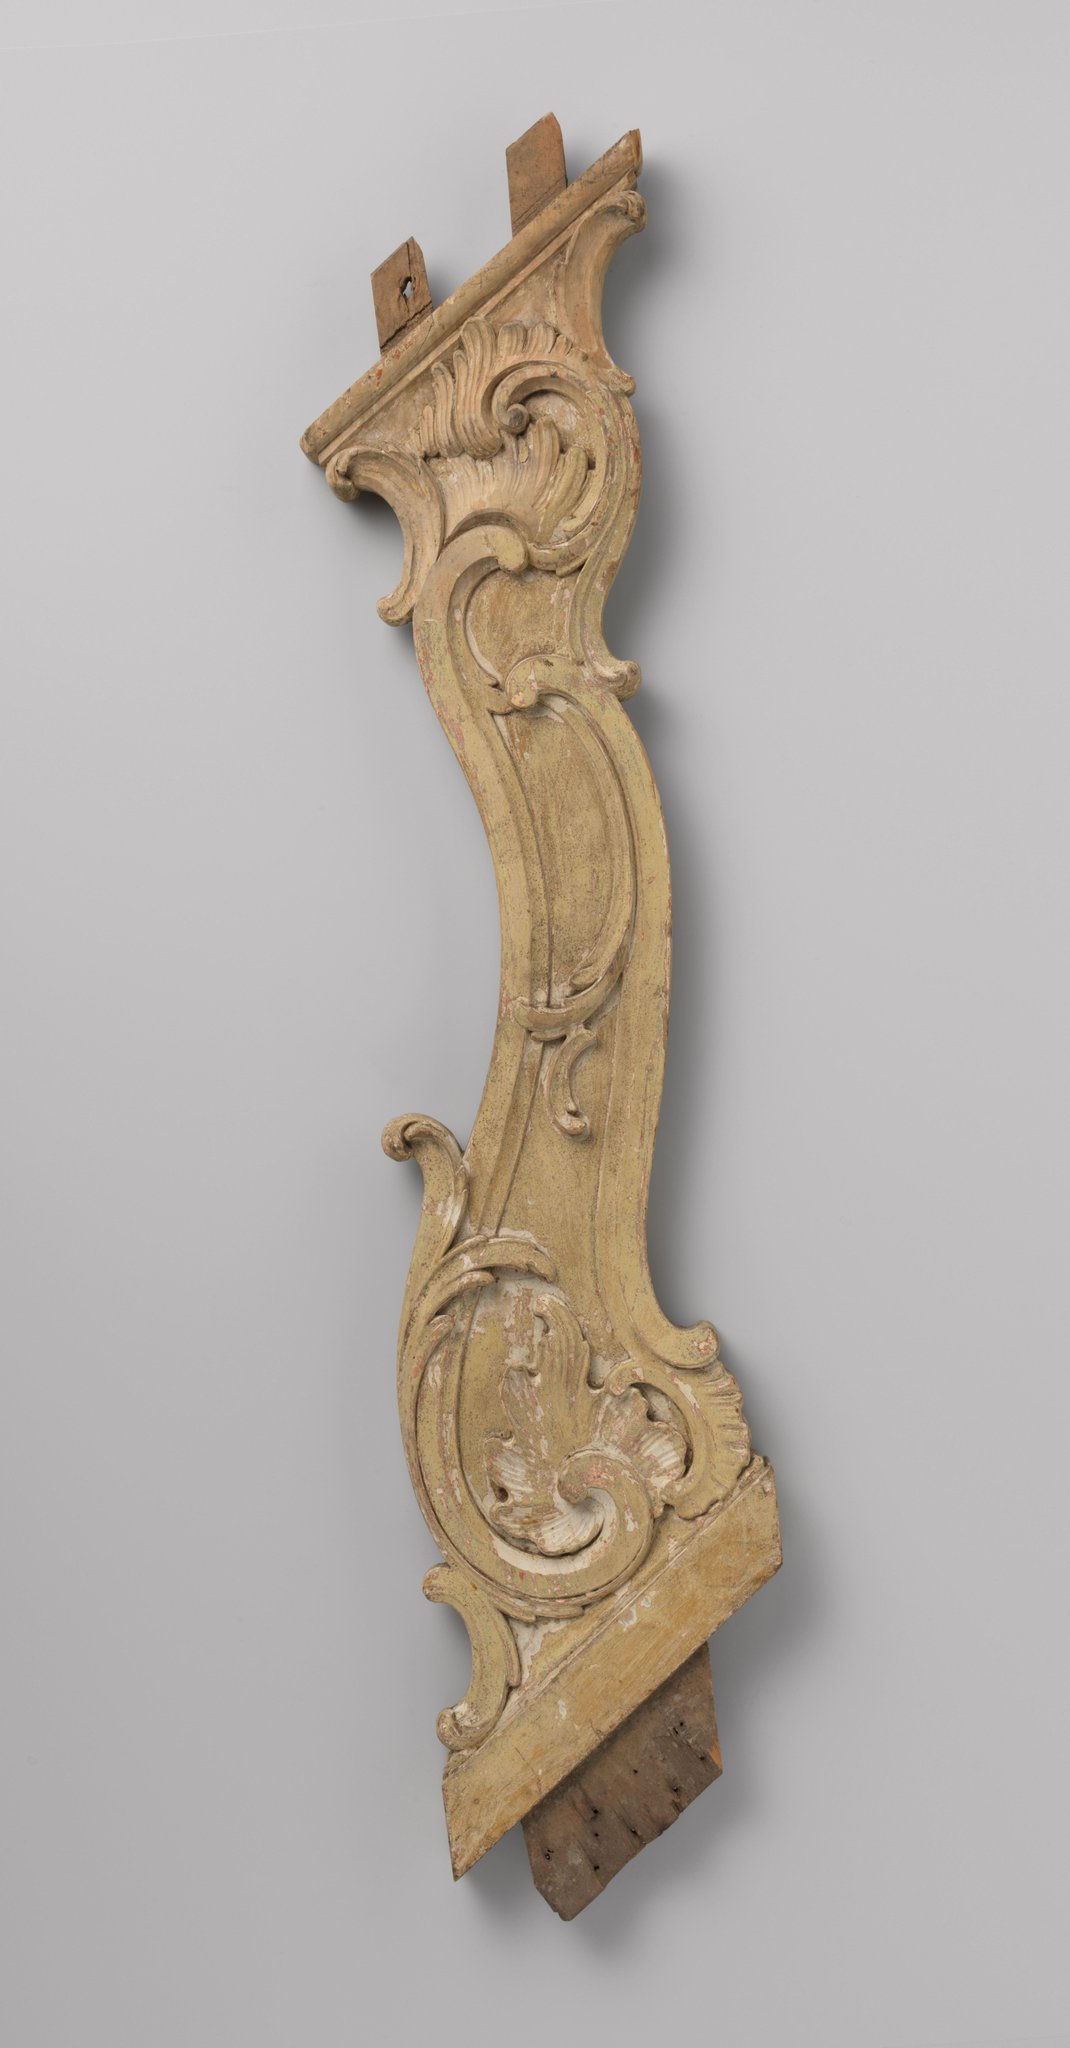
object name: architectural element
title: Baluster met gestoken C- en S-voluten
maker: Anonymous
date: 1740-1760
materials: wood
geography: northern netherlands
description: S-vormige baluster met gestoken C- en S-voluten met rocaille-schelpen.